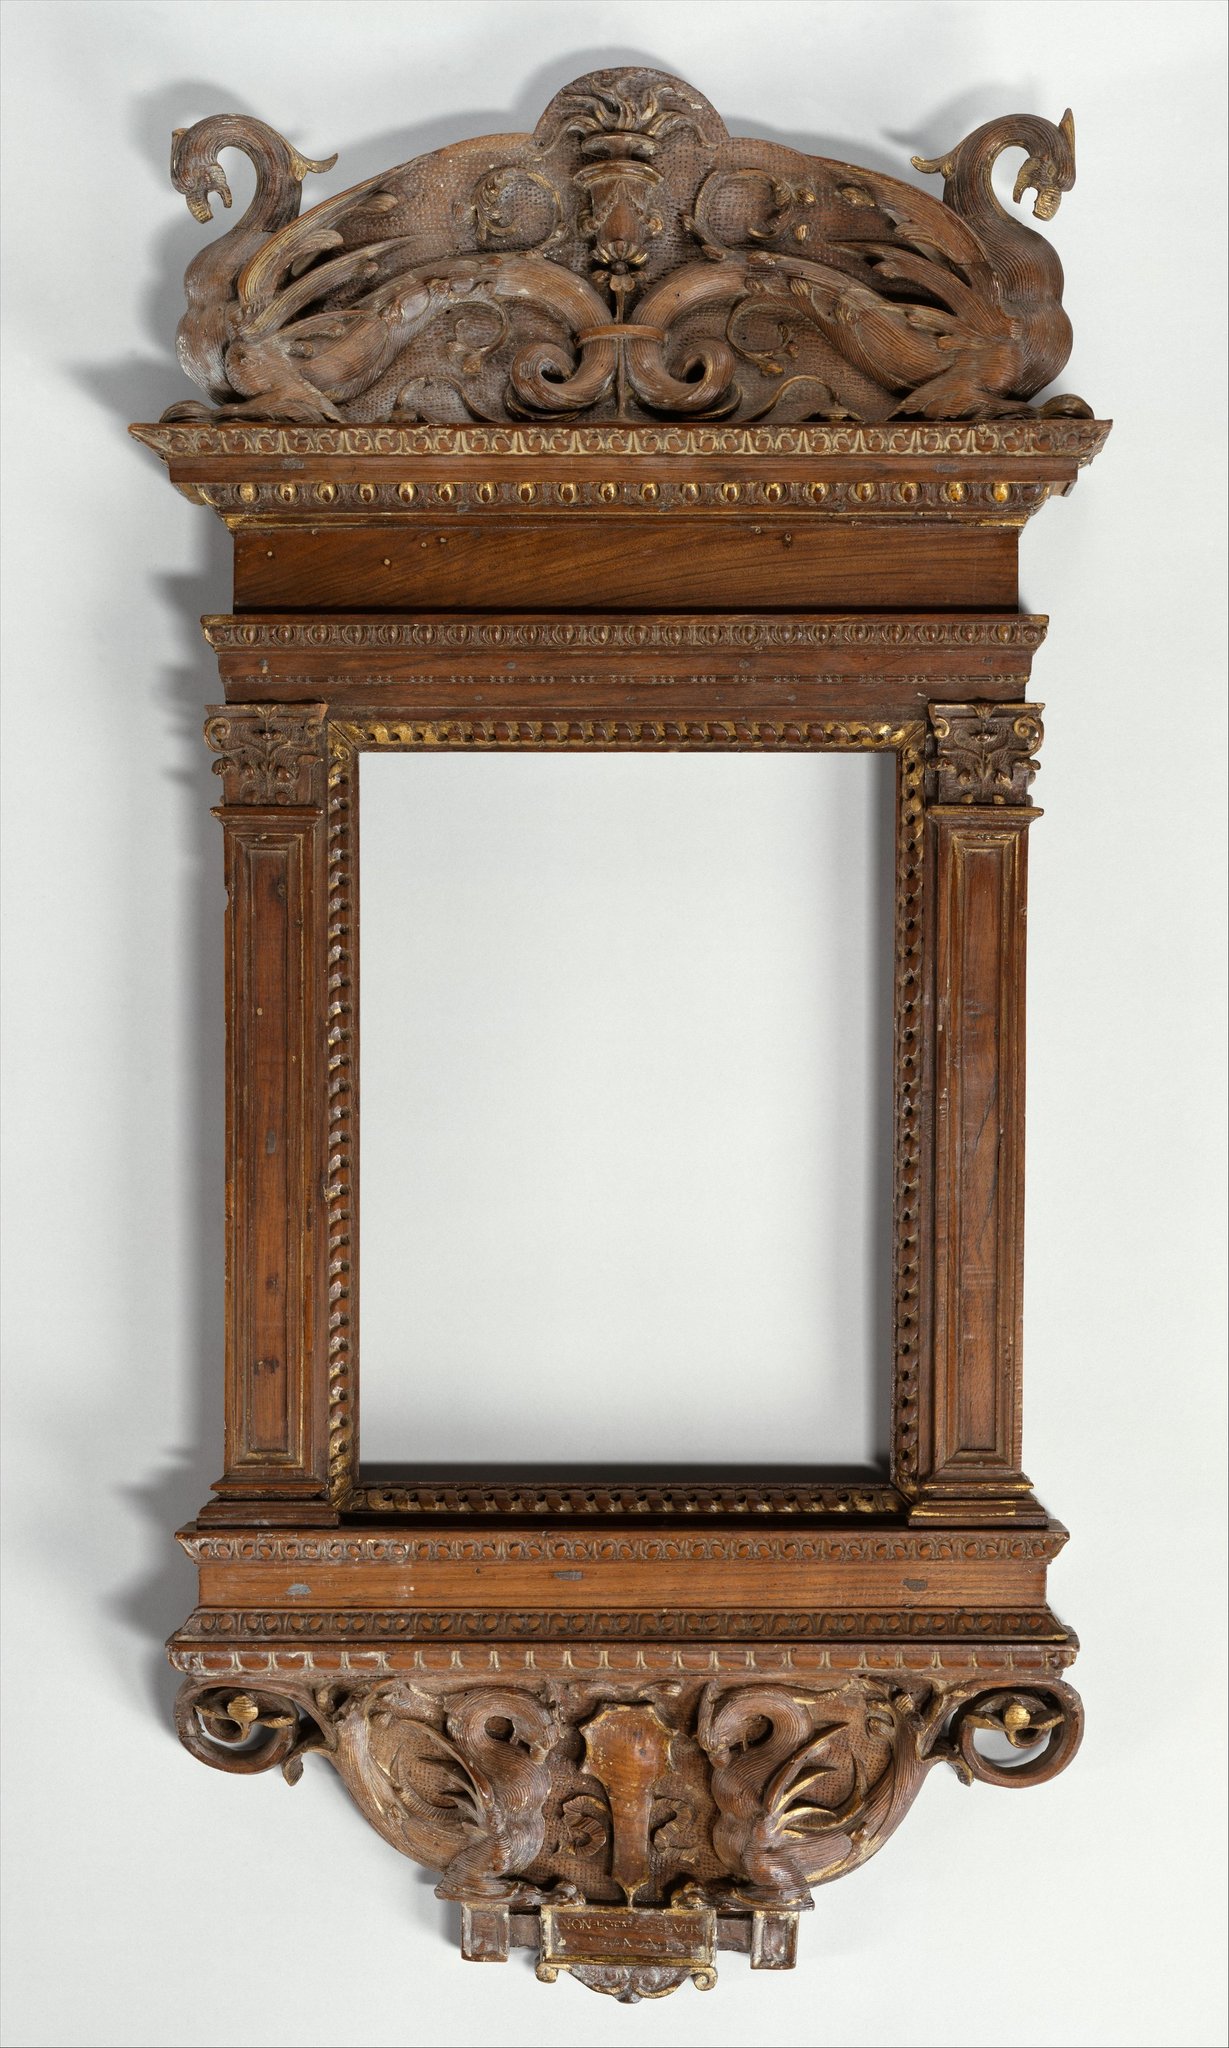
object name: tabernacle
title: Tabernacle frame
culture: italian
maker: del tasso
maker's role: artist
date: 1530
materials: wood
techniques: carving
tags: griffins